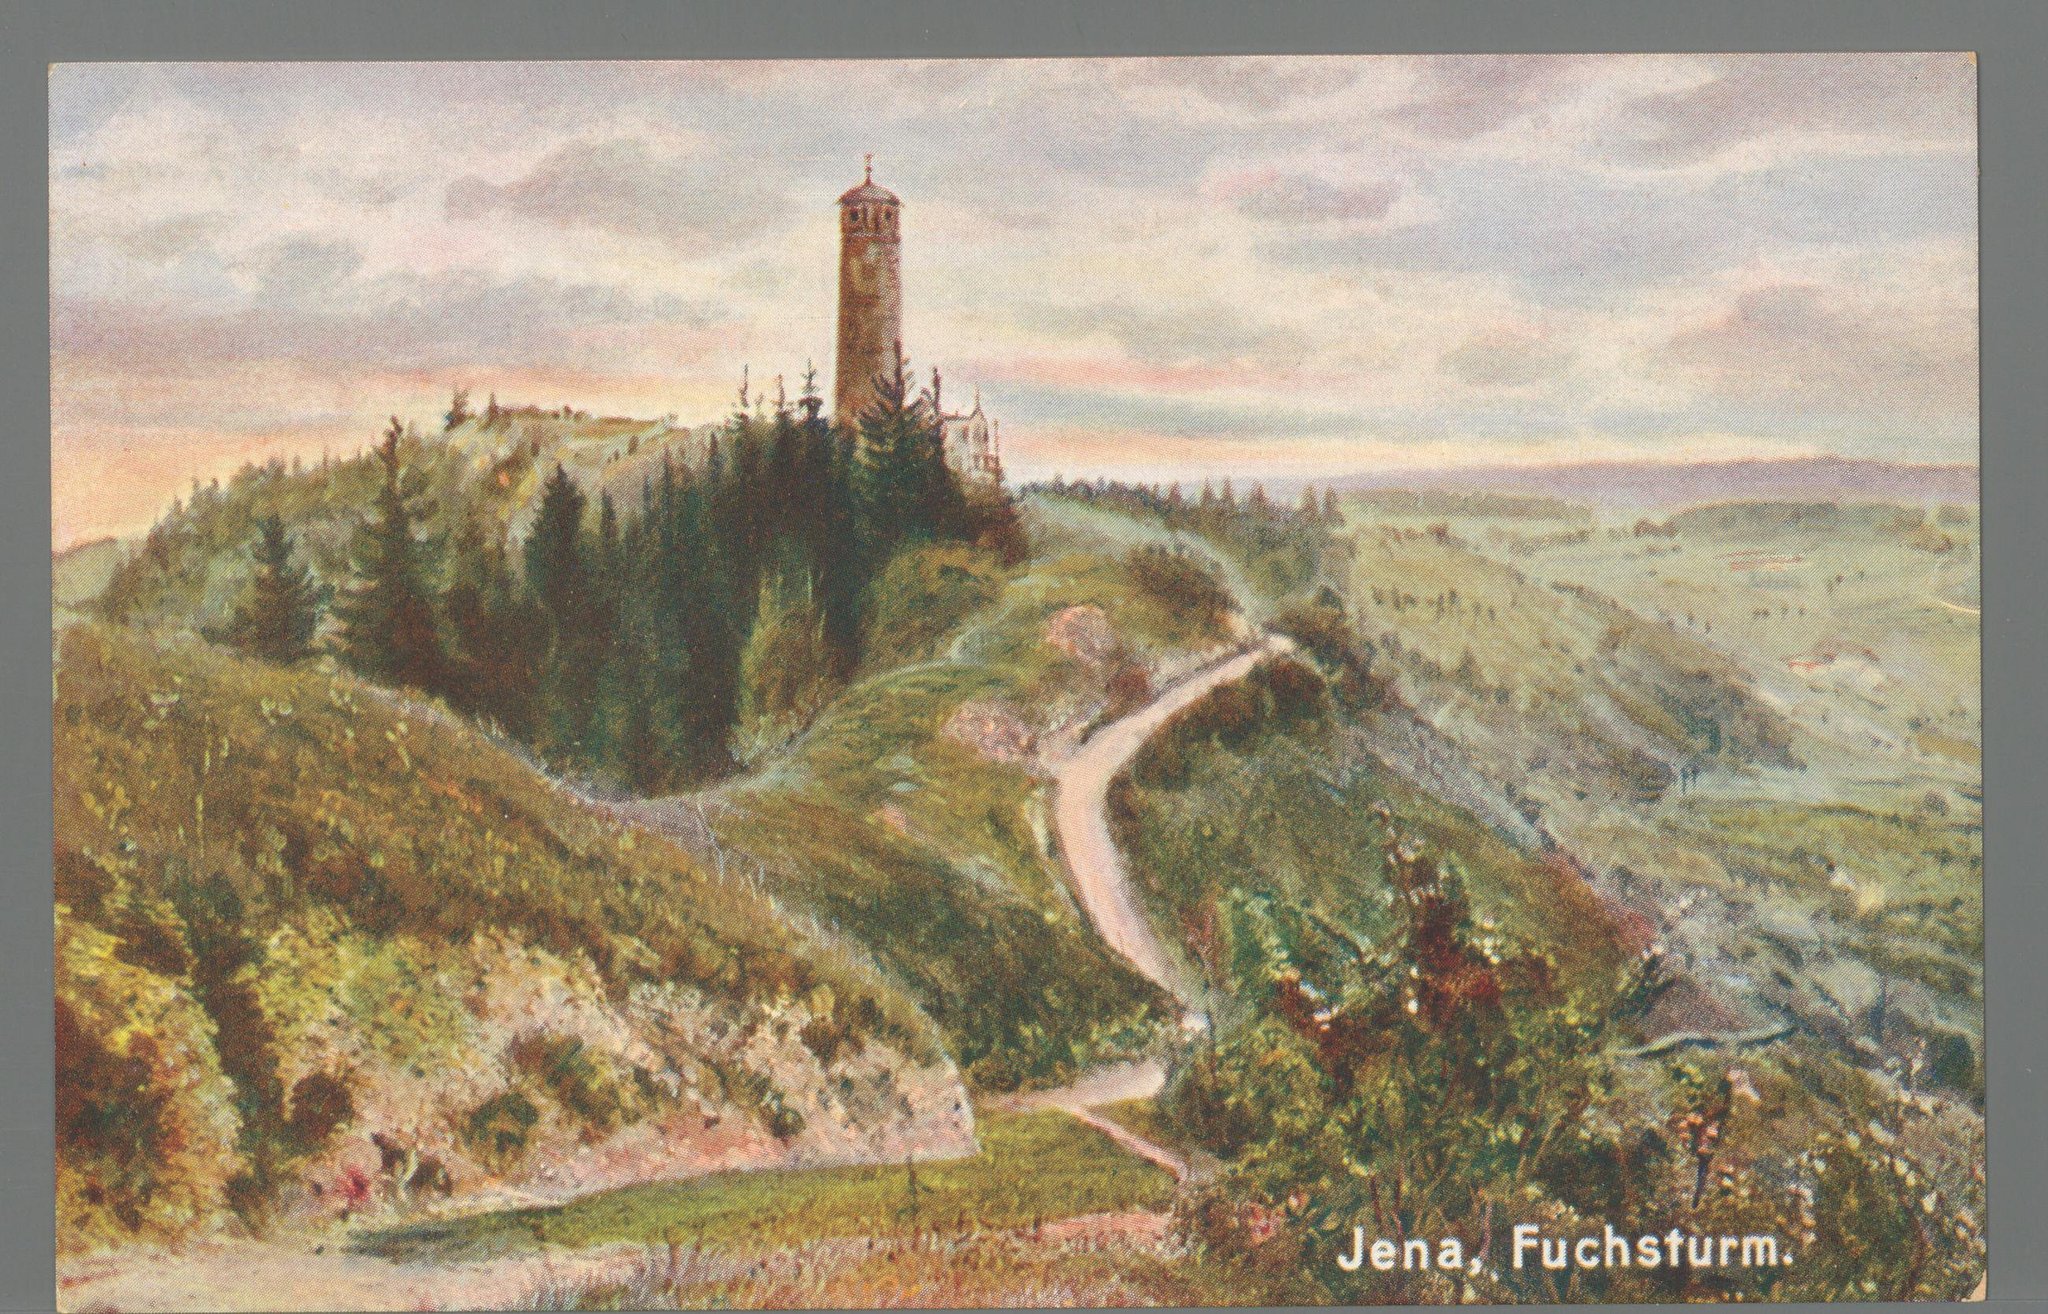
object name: photomechanical print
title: Jena, Fuchsturm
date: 1907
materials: cardboard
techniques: color autotype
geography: jena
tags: towers ~ fortified city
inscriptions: monogram